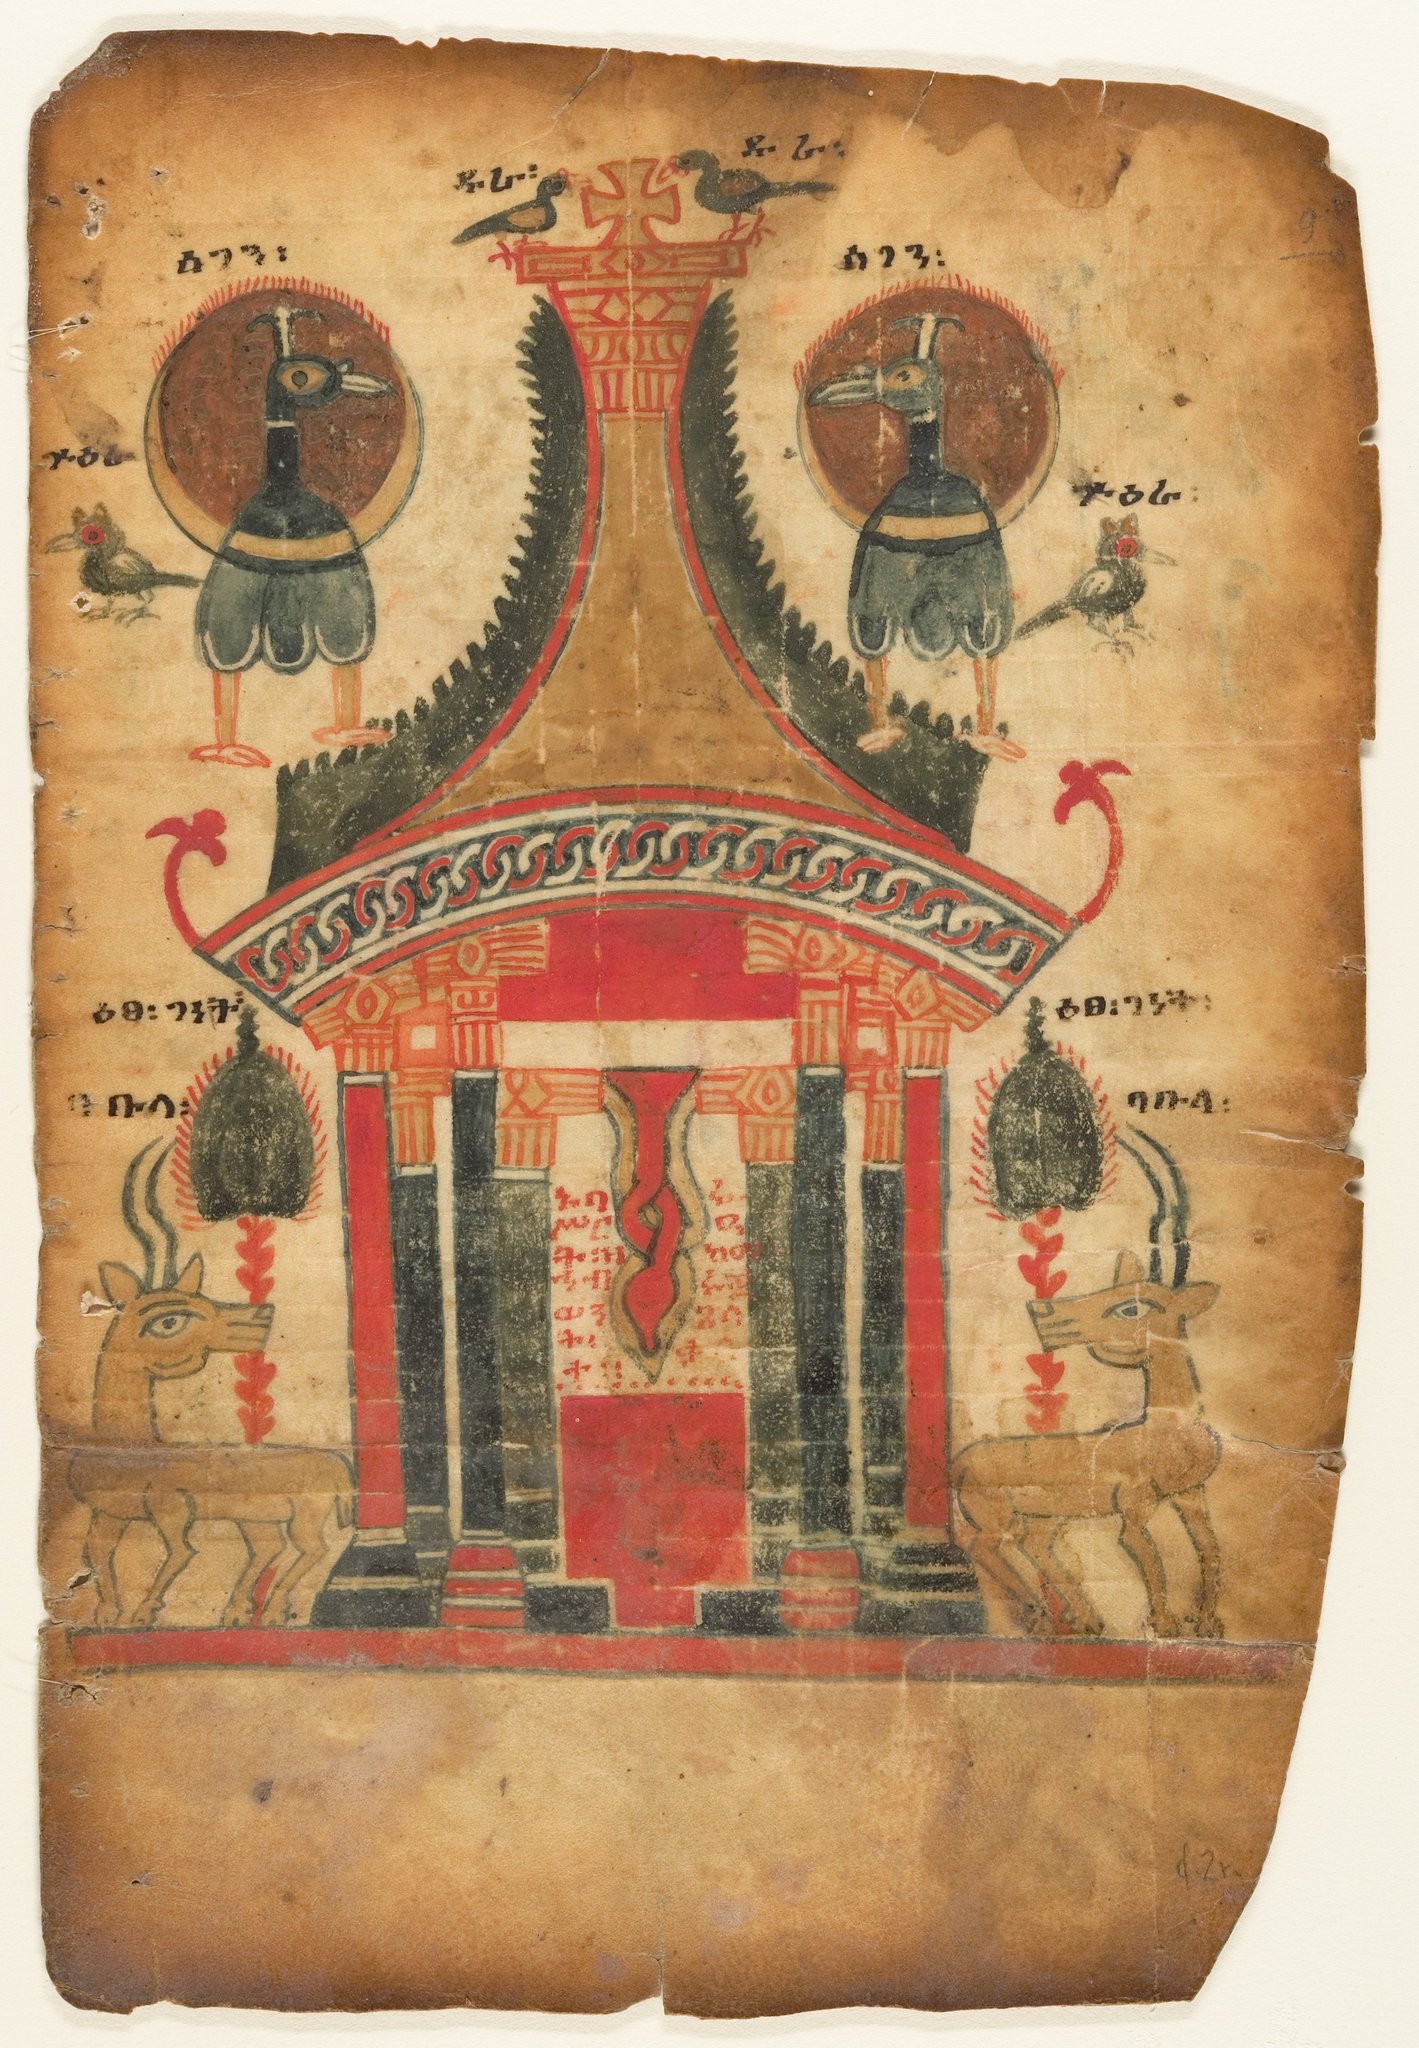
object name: gospel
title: Double-Sided Gospel Leaf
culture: ethiopian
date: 1301-1350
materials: parchment, paint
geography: ethiopia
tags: animals,birds,men